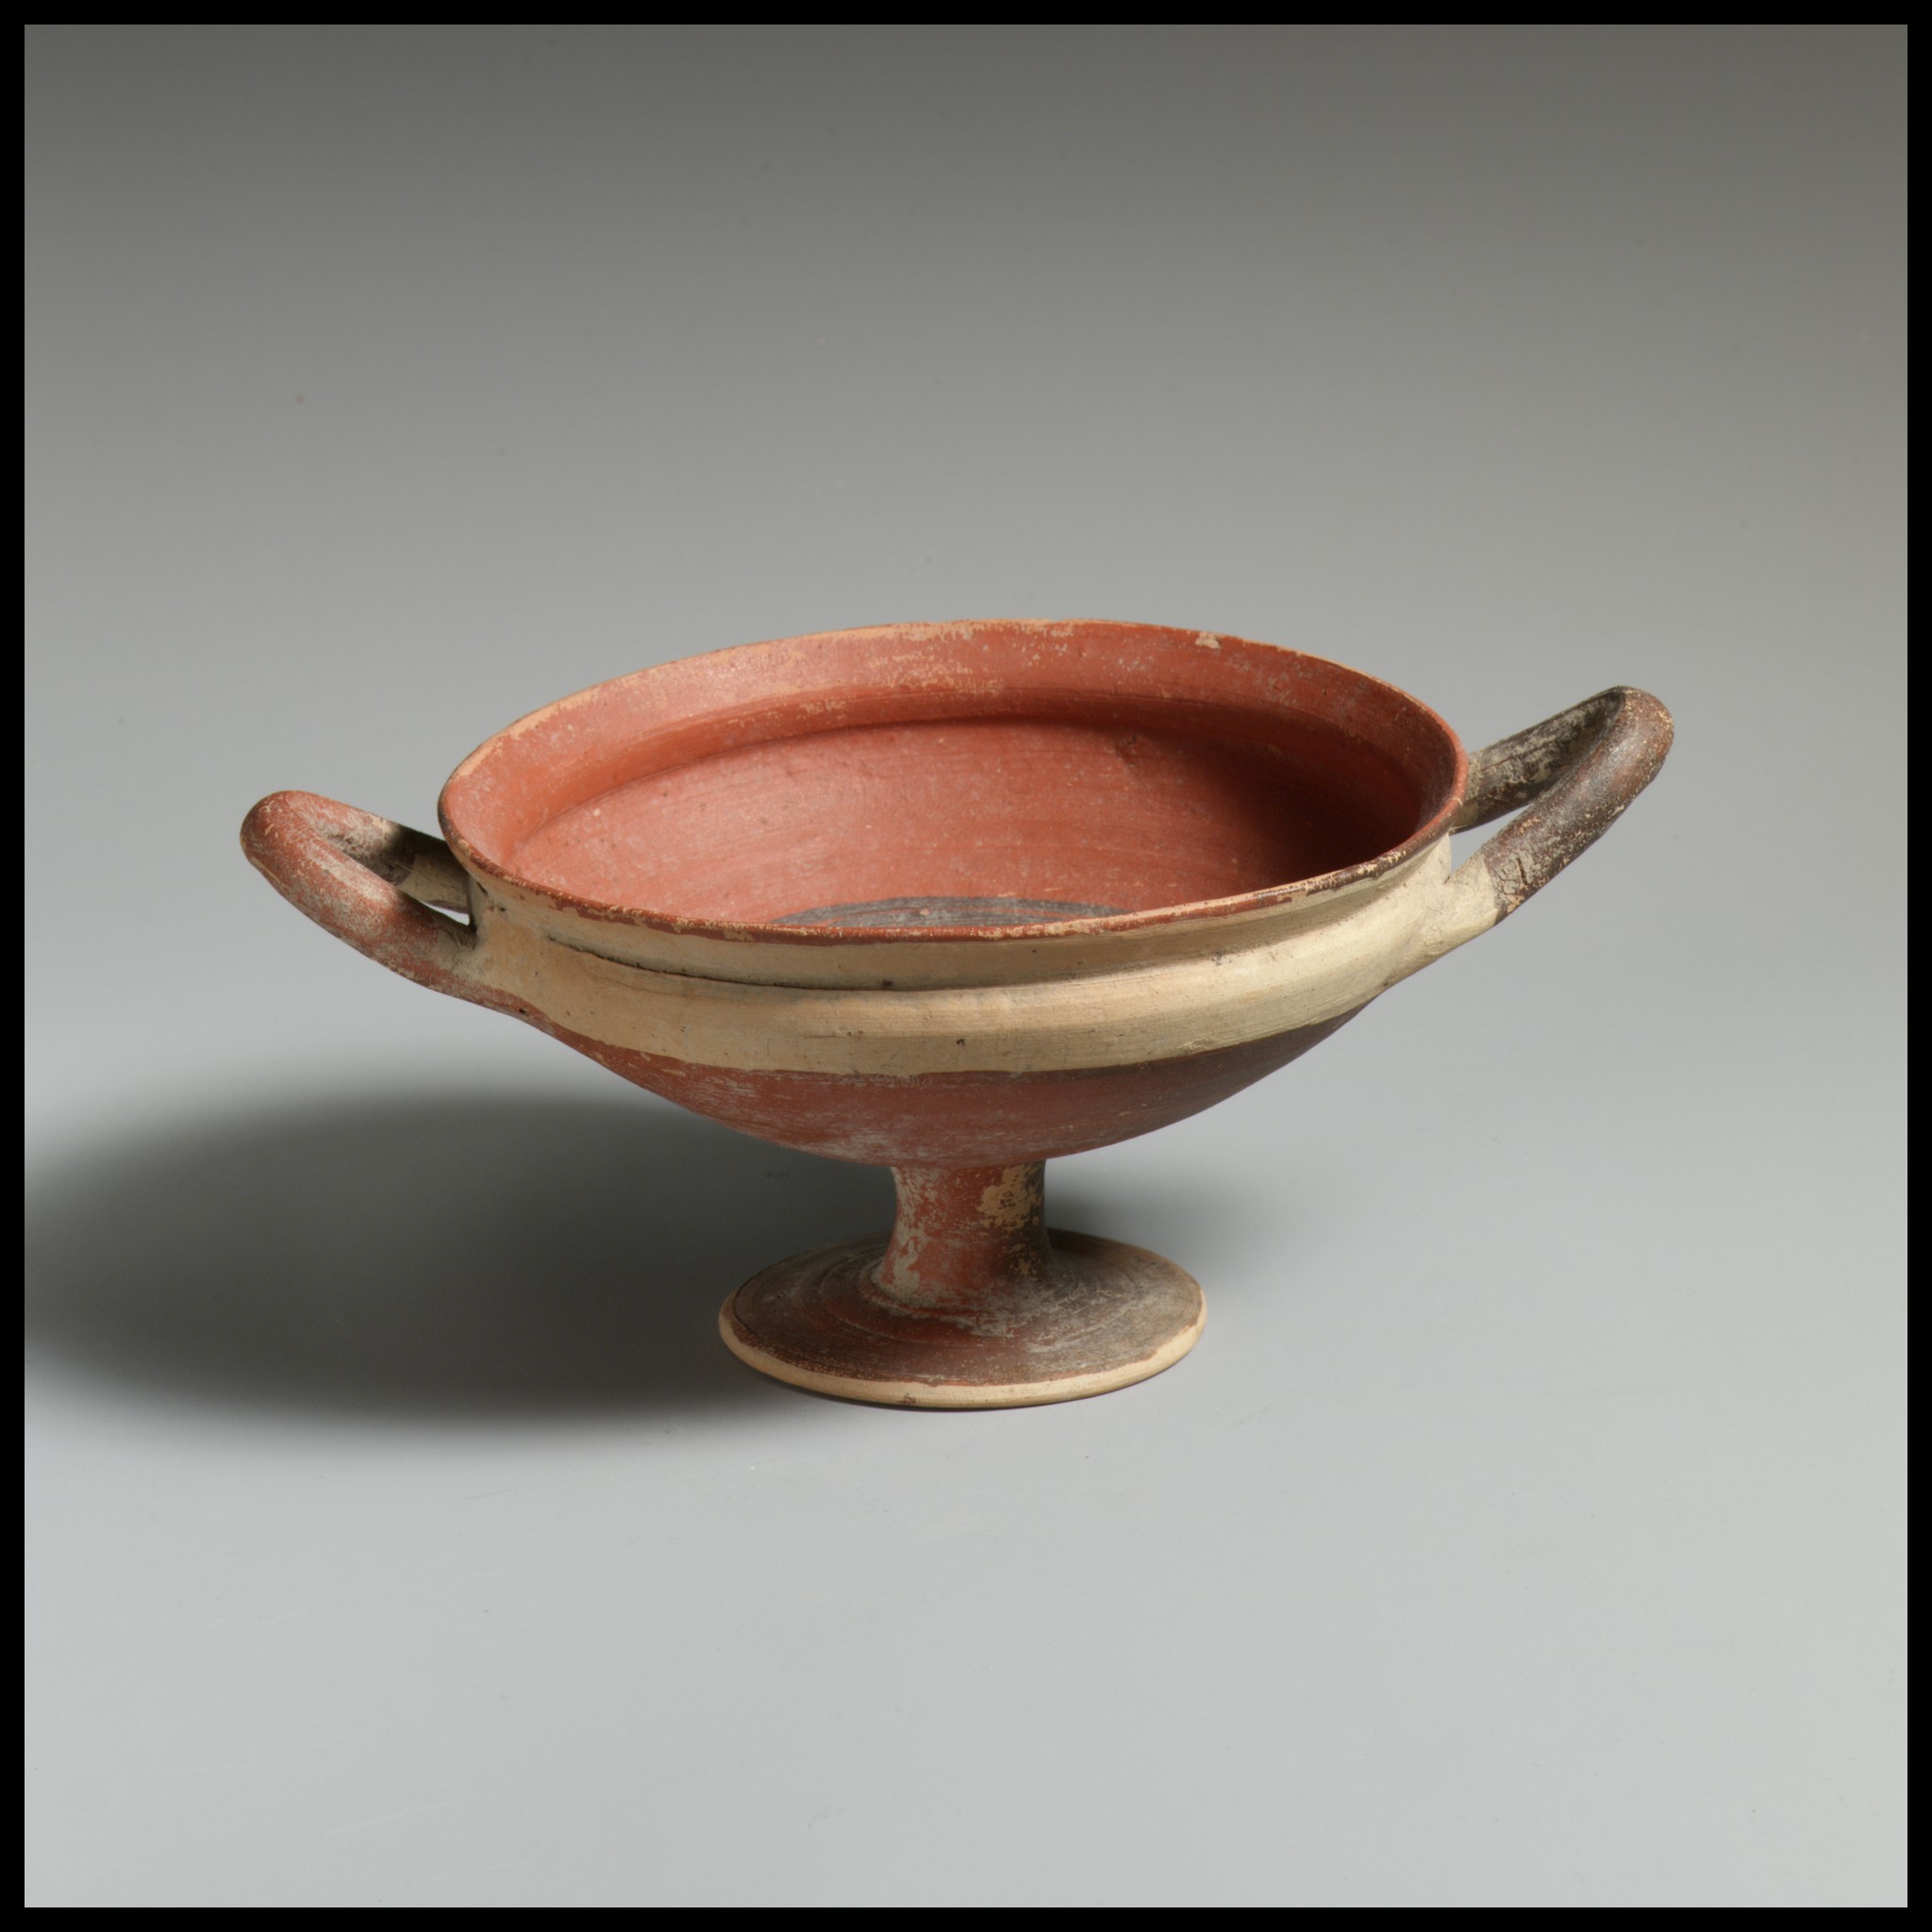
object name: kylix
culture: italic, daunian or south italian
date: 500-401 BCE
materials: terracotta